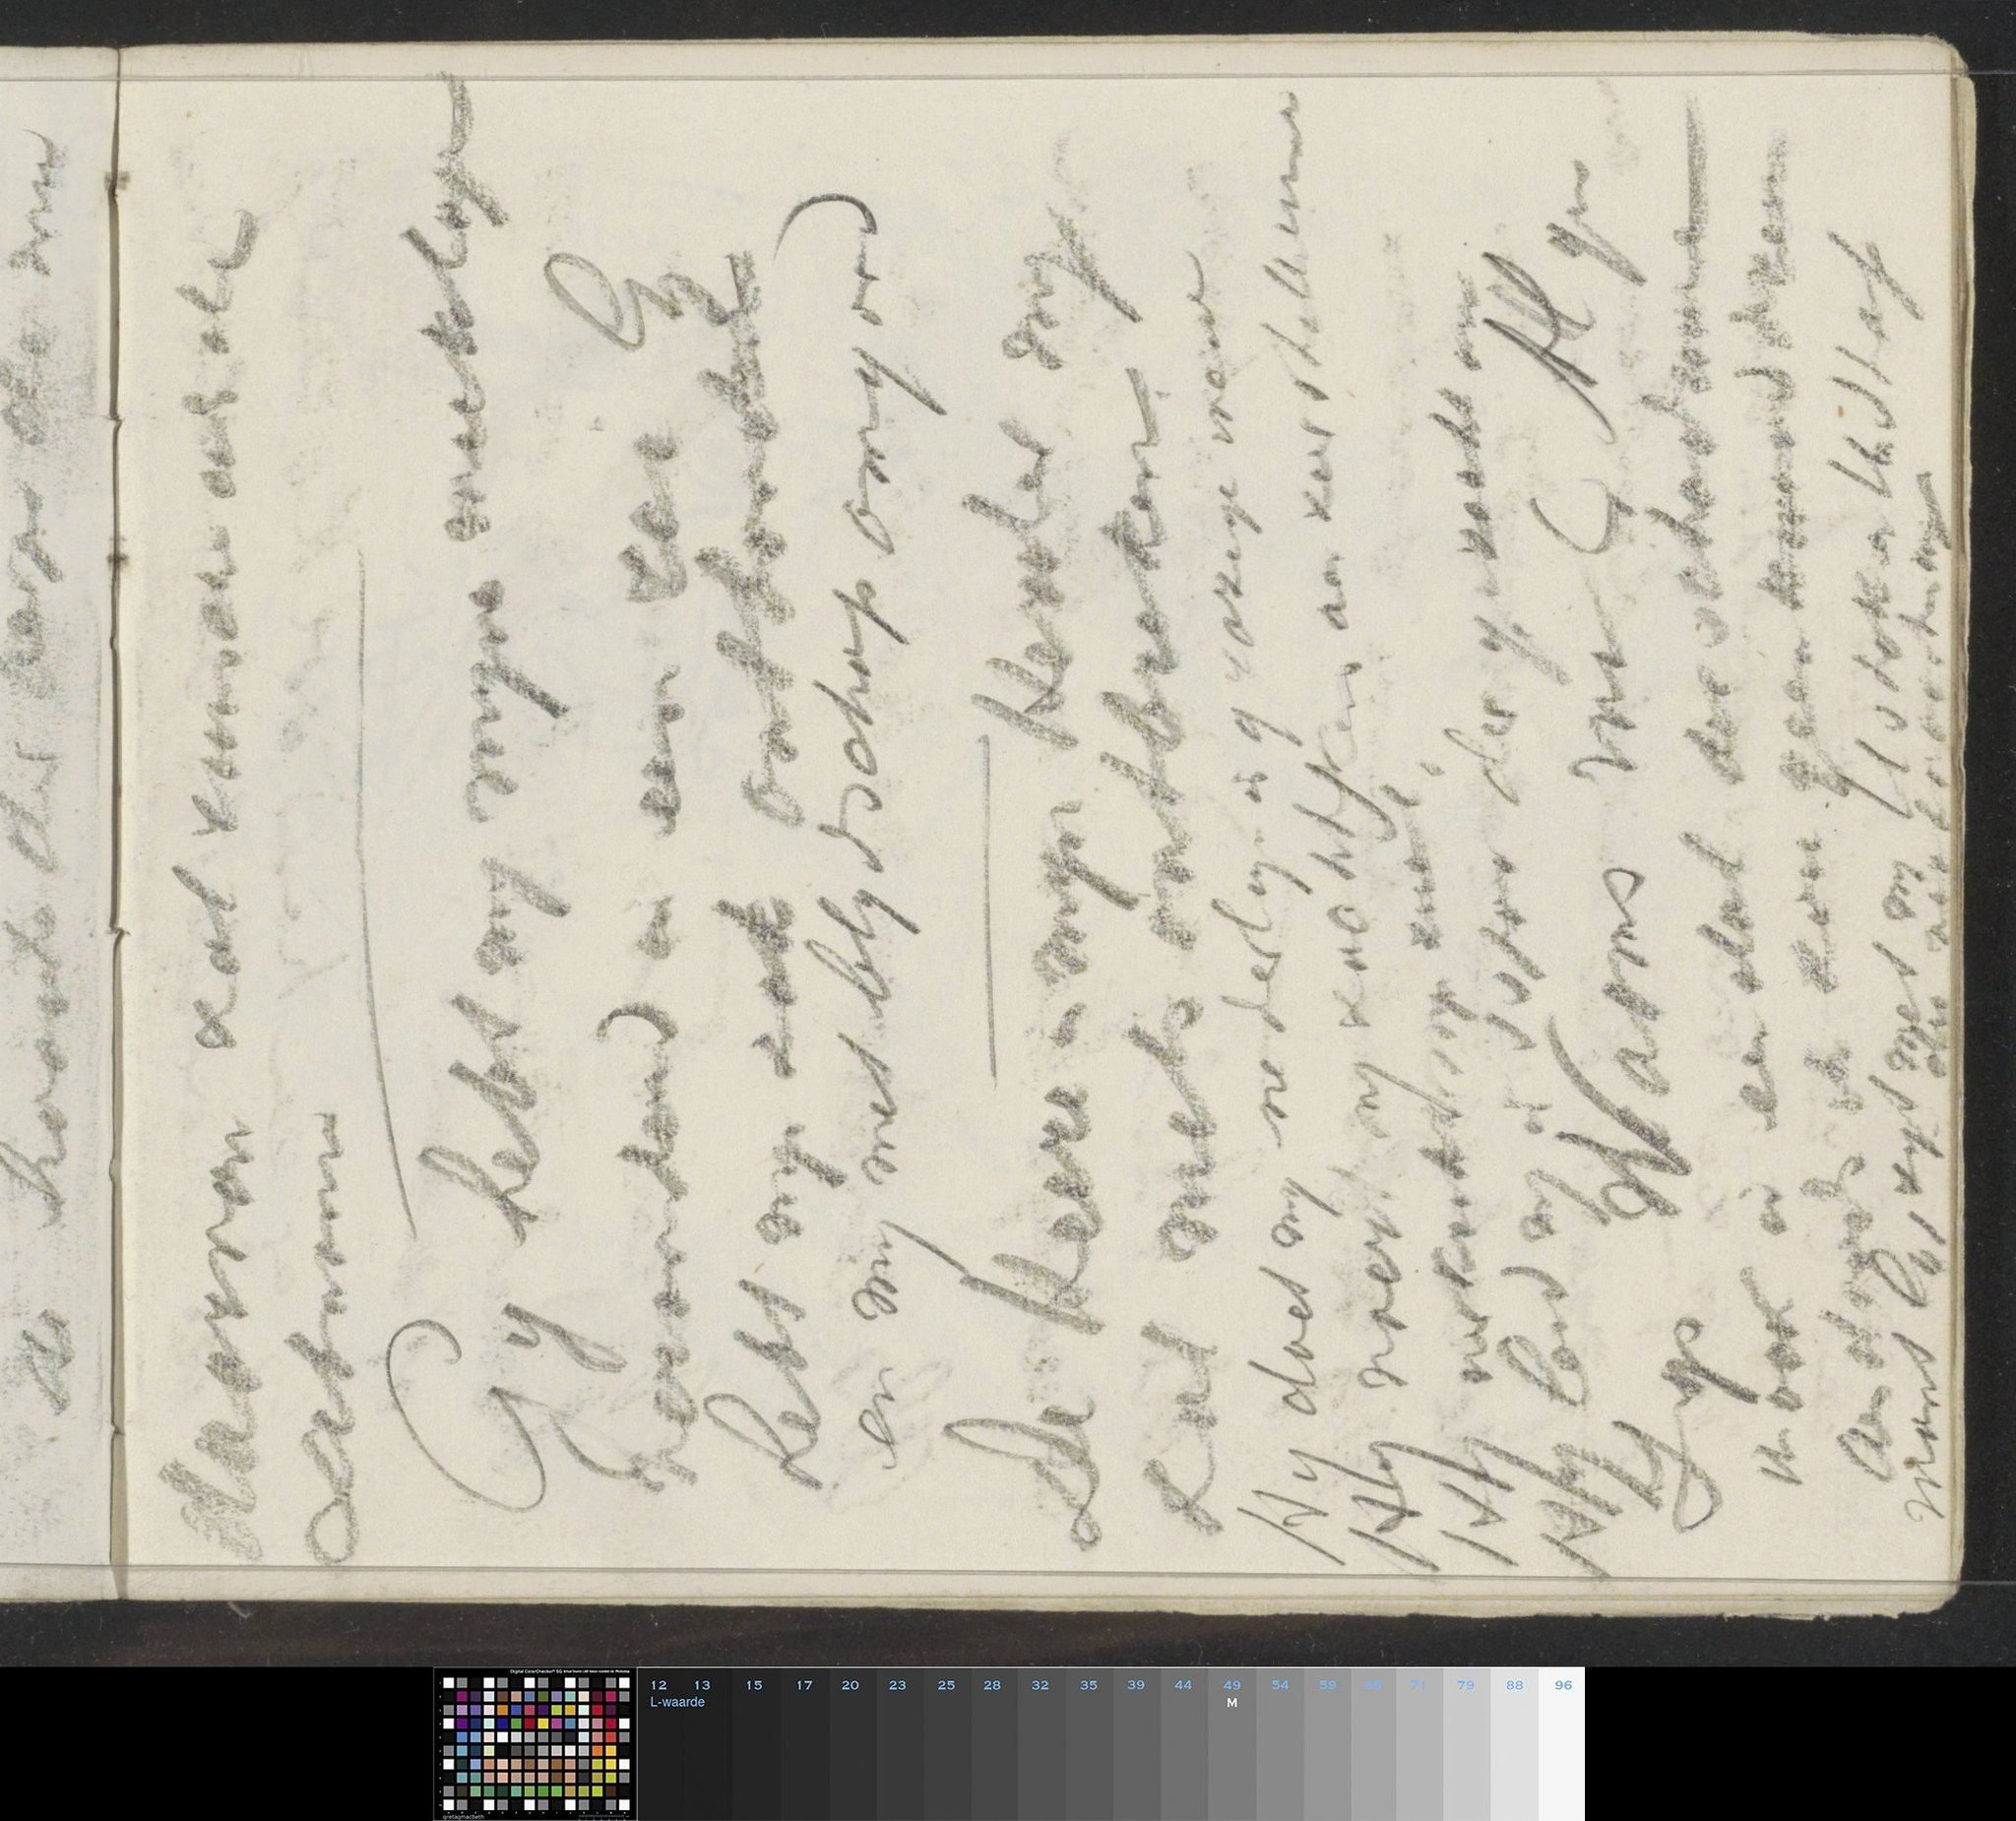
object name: sketchbook leaf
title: Fragmenten uit psalmen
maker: carel adolph lion cachet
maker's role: draughtsman, print maker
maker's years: 1864-1945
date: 1895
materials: chalk, paper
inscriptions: annotation: ‘daarvan zal ruisen als de/ Libanon/ Gij hebt mij mijn weeklage/ veranderd in een rei/ G hebt mijn zak ontbonden/ en mij met blijdschap omgord/ De Heere is mijn Herder mij/ zal niets ontbreken/ Hij doet mij nederliggen in grazige weiden [...]’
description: Blad 4 recto uit een schetsboek met 11 bladen.